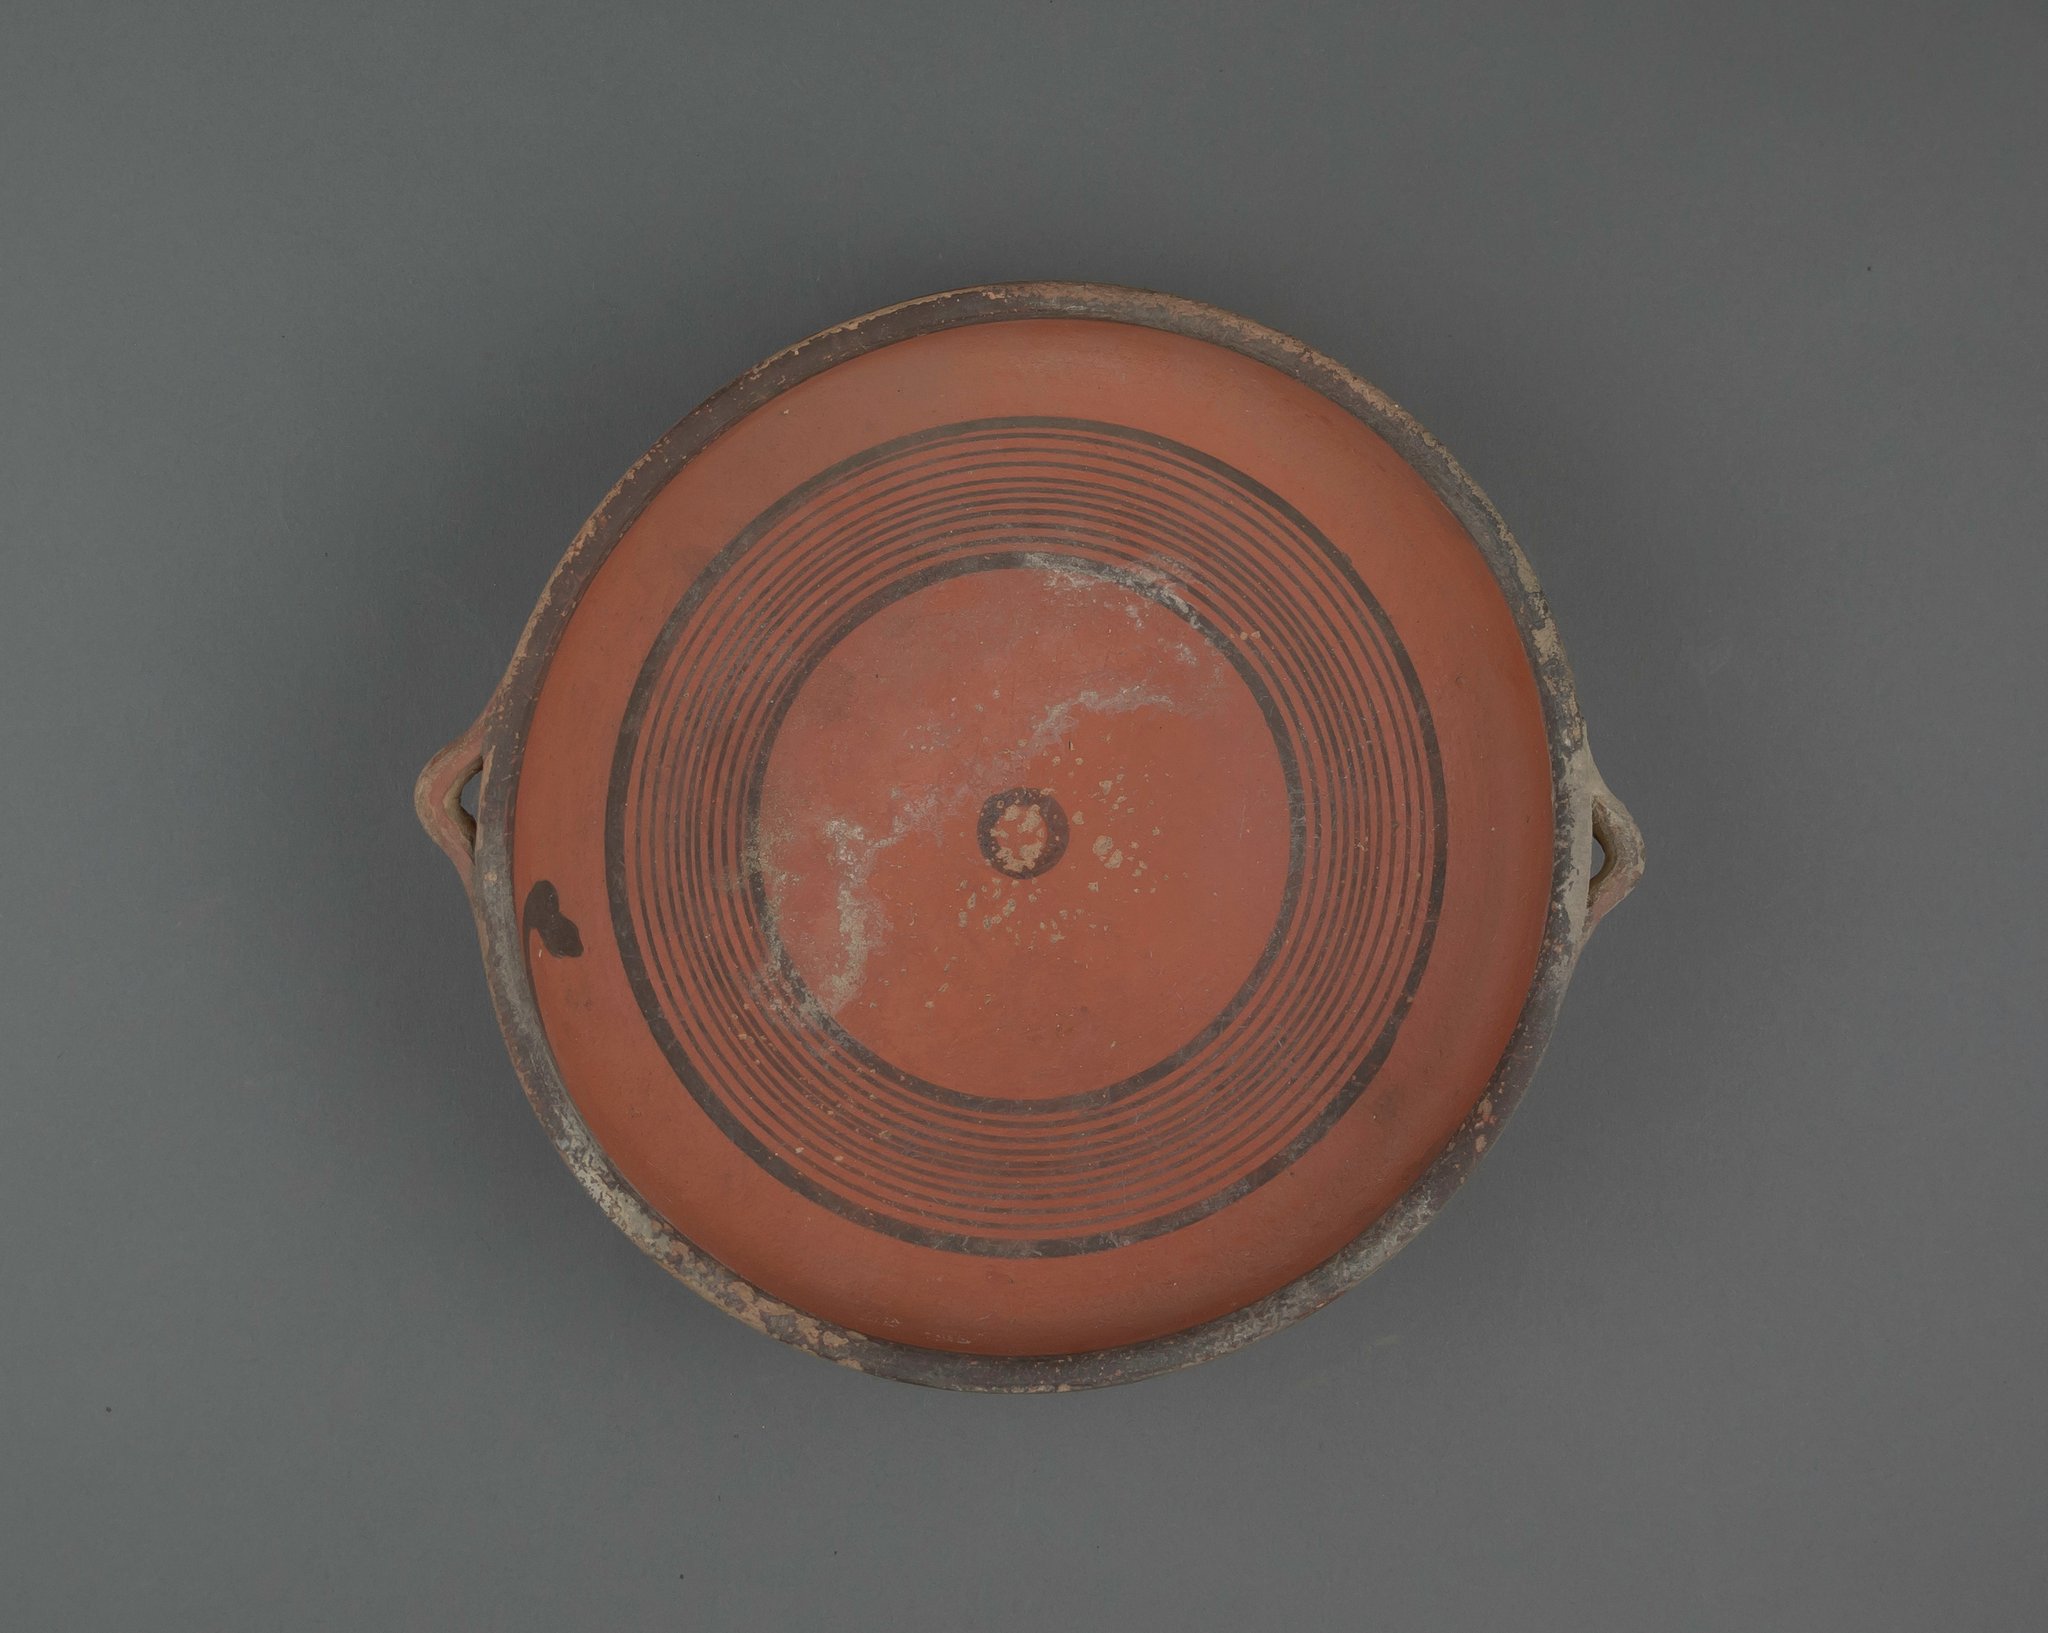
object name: bowl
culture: cypriot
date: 1050-900 BCE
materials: terracotta